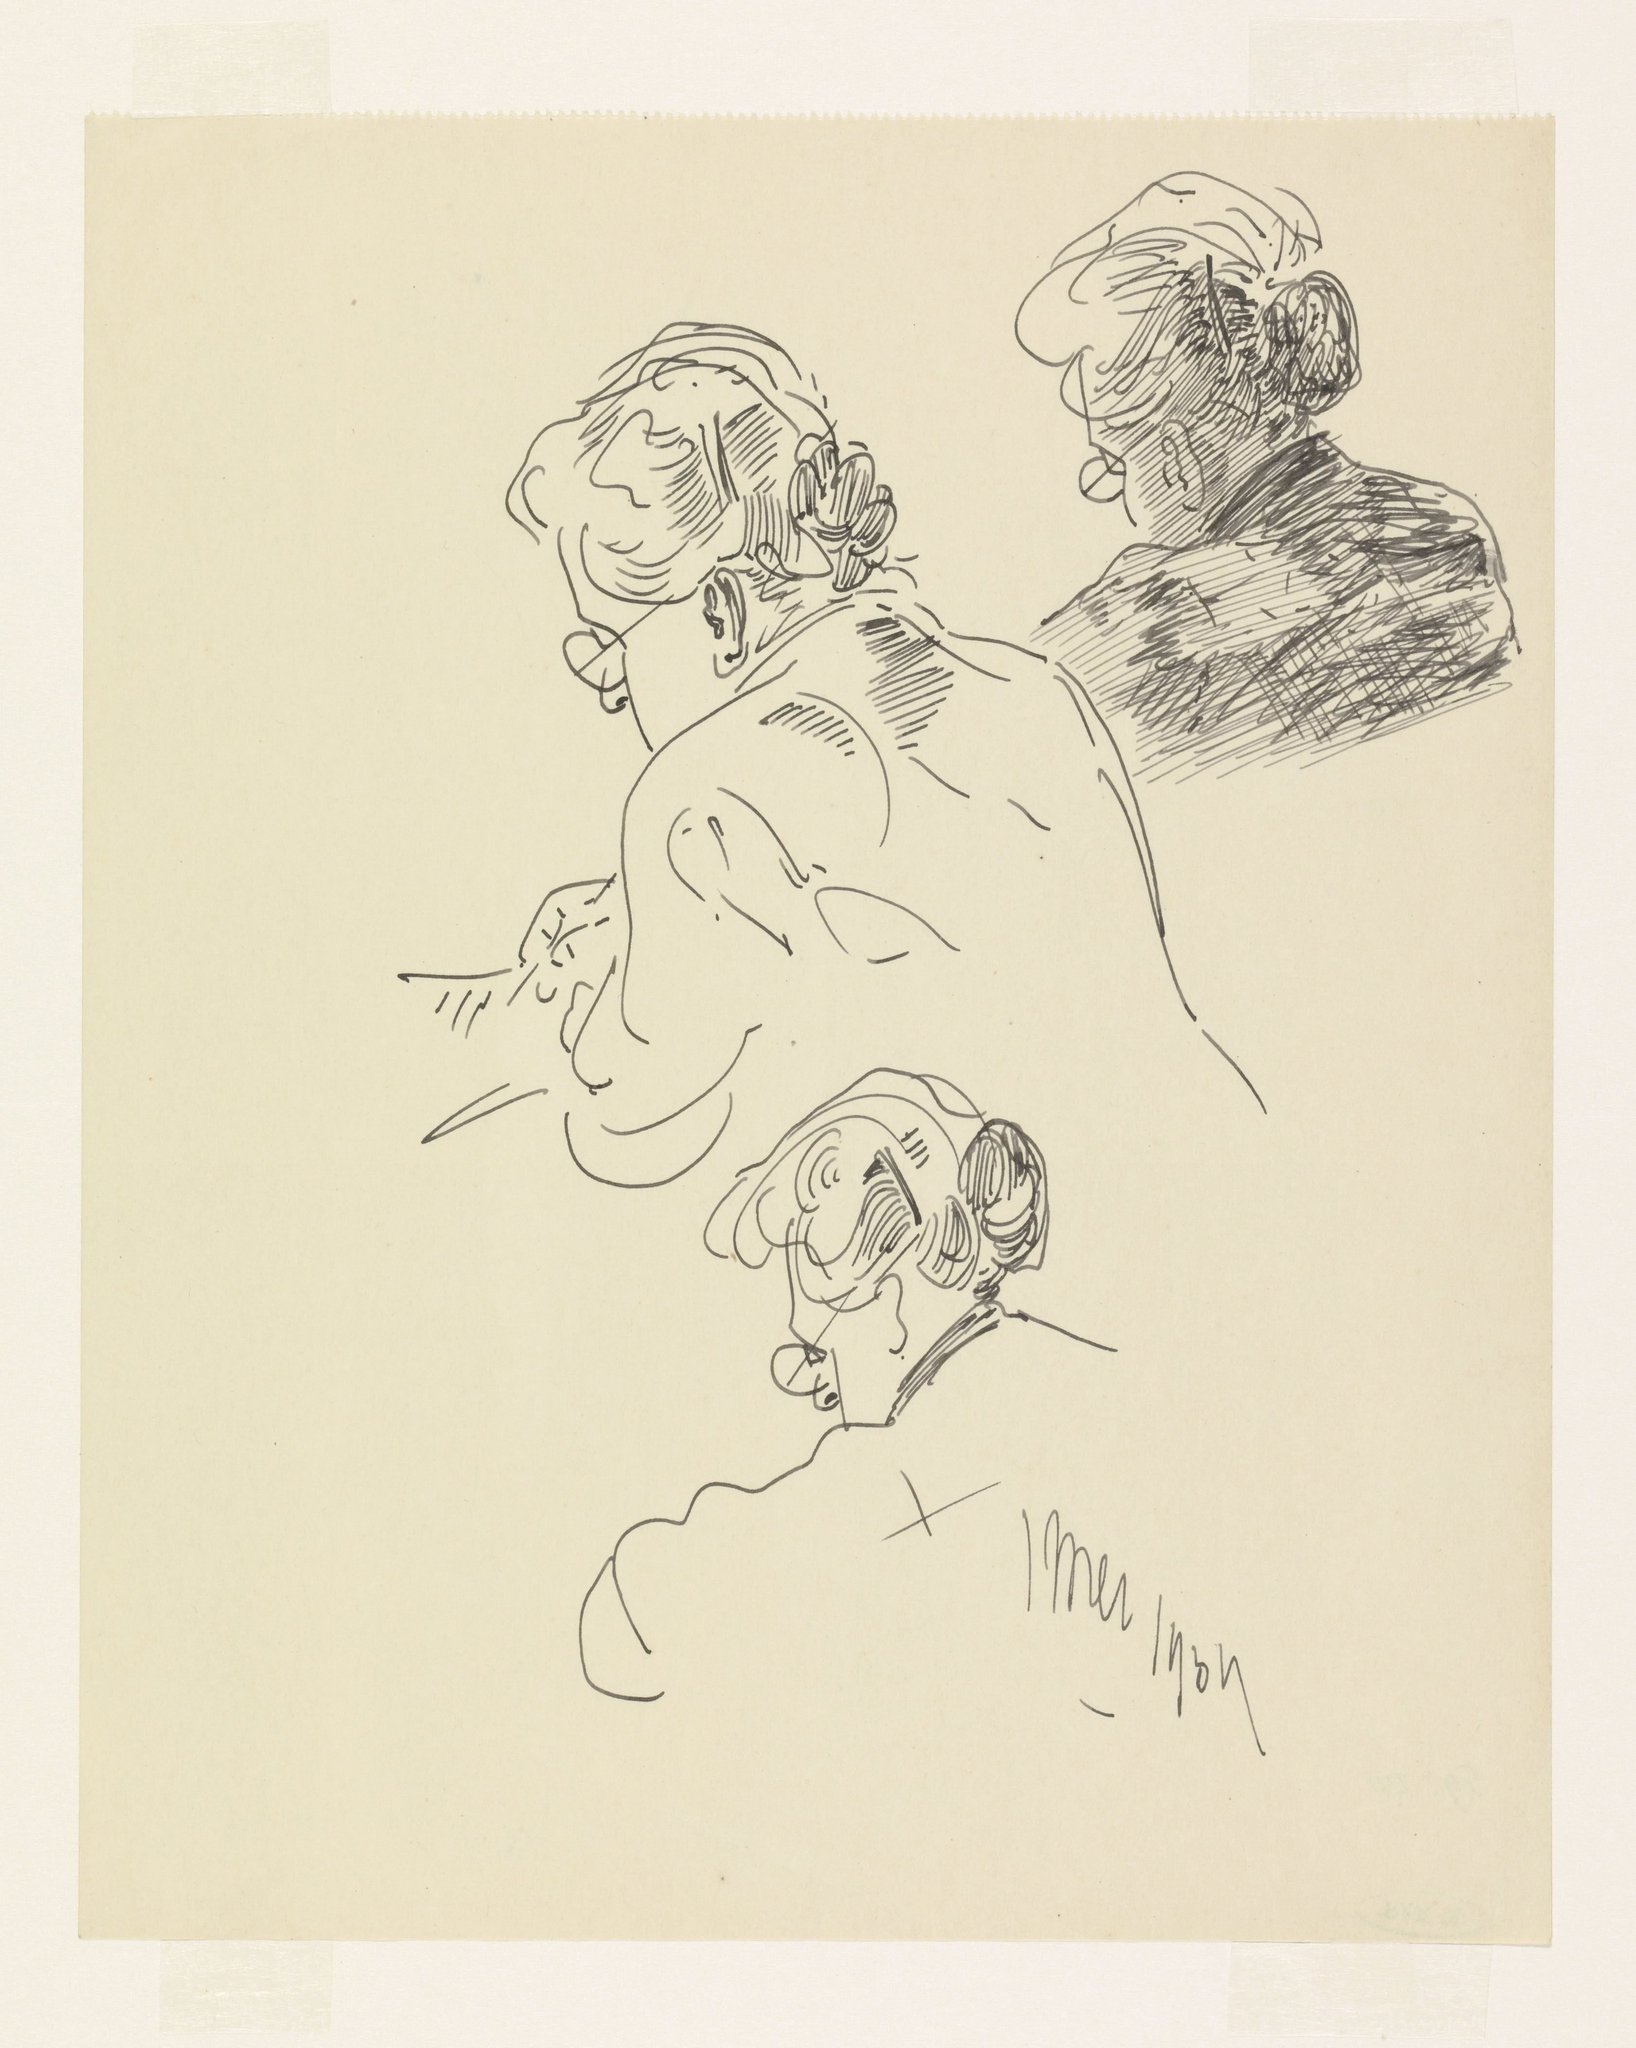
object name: drawing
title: Studies van de echtgenote van Carel Adolph Lion Cachet, handwerkend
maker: carel adolph lion cachet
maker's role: draughtsman, print maker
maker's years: 1864-1945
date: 1934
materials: ink, paper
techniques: pen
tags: historical persons - bb - woman, (other forms of) needlework, e.g.: crocheting, knitting, embroidering